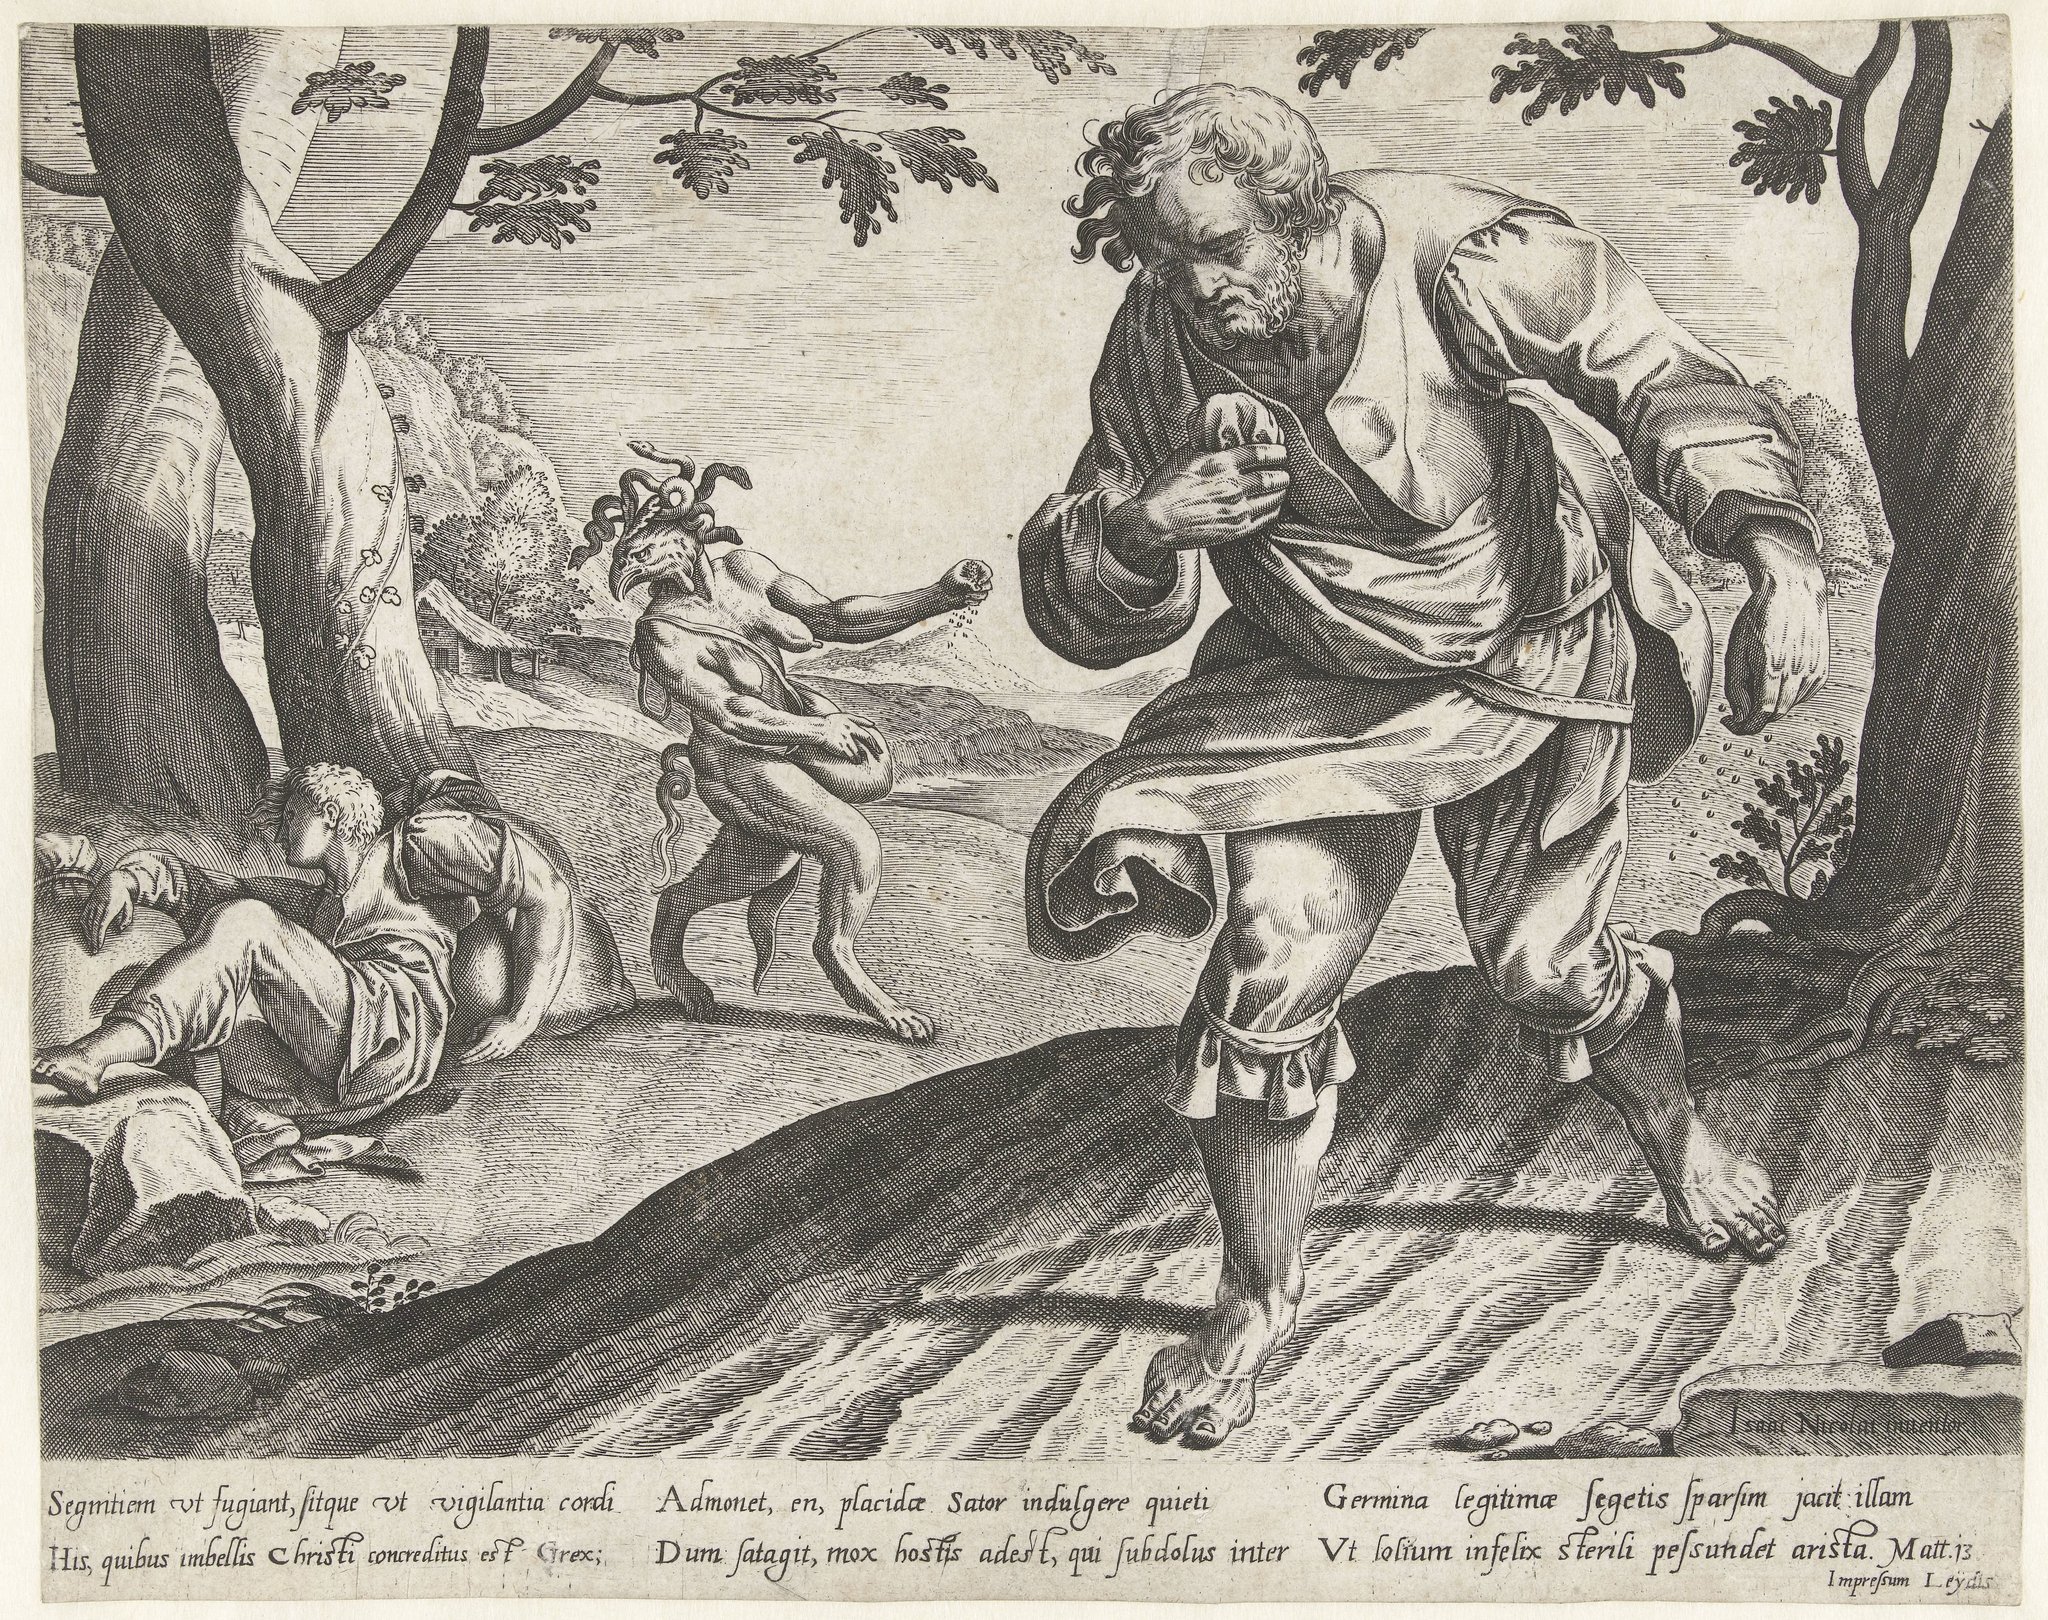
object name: print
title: Gelijkenis van het onkruid tussen het koren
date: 1589-1600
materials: paper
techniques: engraving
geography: leiden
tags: tares among the wheat ~ parable of christ (matthew 13:24-30), sowing, human-shaped devil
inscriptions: collector's mark: Lugt 2760, collector's mark: Lugt 2228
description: Rechts op de voorgrond zaait de zaaier het graan op zijn akker. Links op de achtergrond zaait de duivel onkruid, terwijl de zaaier ligt te slapen. Onder de afbeelding zes regels Latijnse tekst uit Mattheus 13:24-30.